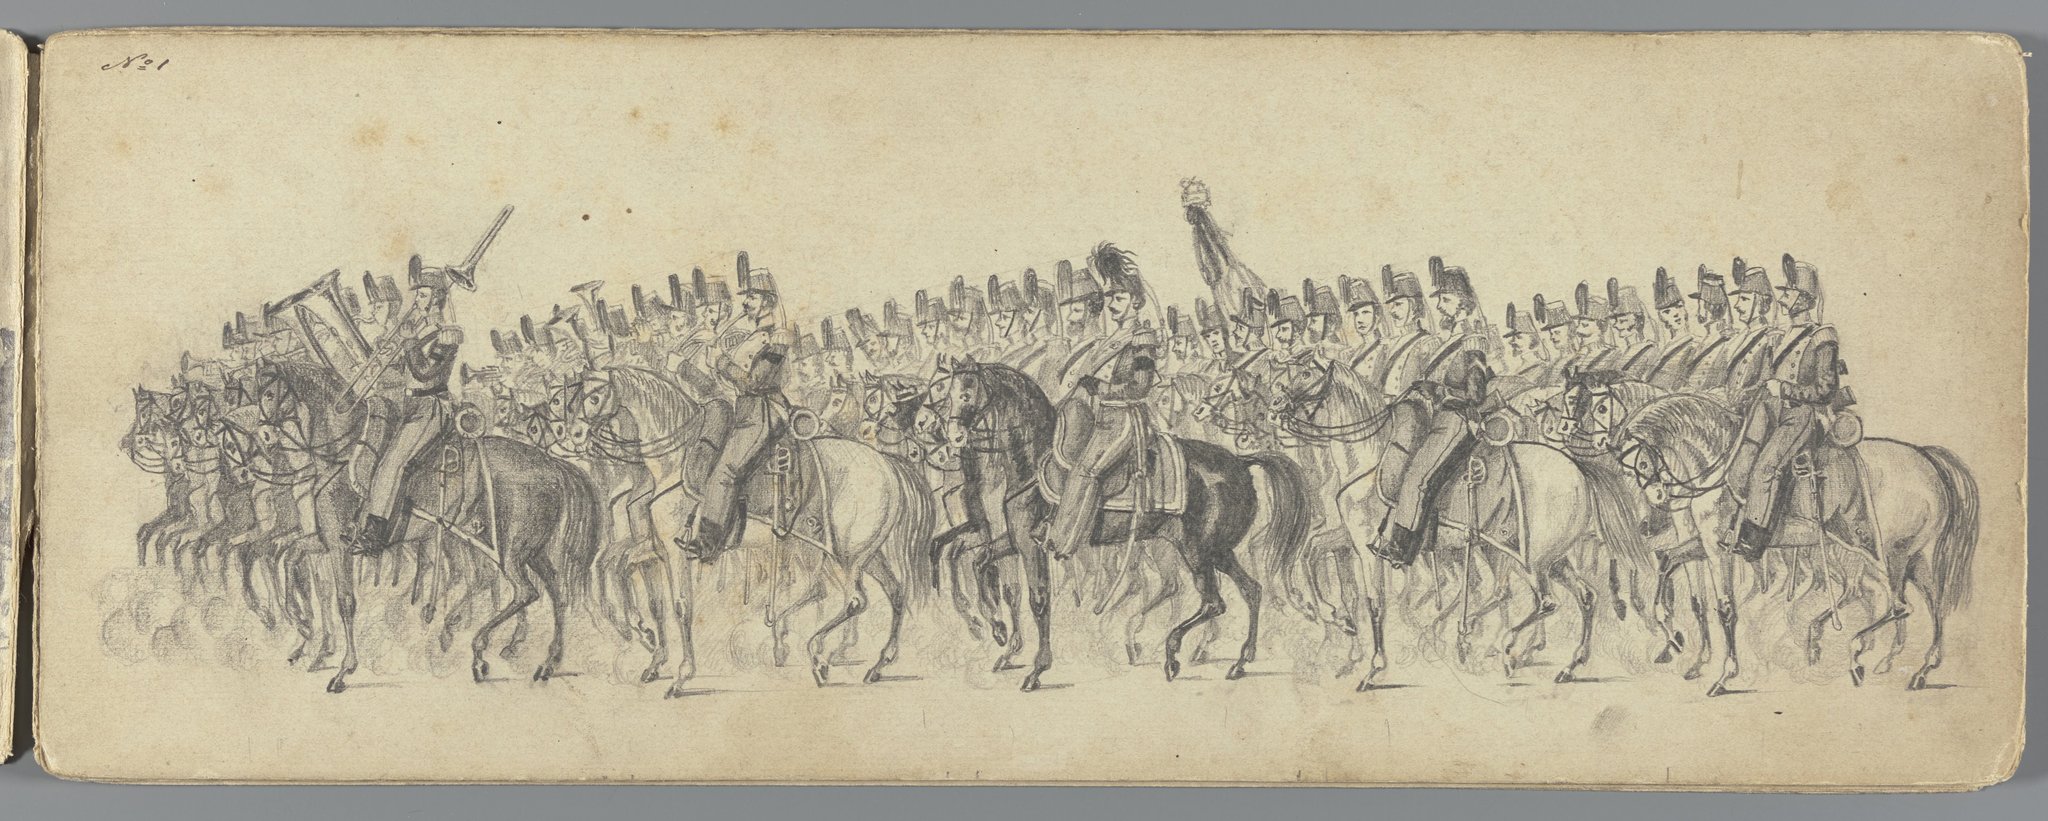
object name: drawing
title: Begrafenisstoet van Anna Paulowna (blad 1), 1865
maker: Anonymous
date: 1865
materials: paper, pencil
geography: netherlands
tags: anna paulowna romanowa, military music, cortege, funeral procession, delft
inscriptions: inscription: ‘No. 1’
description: Muziekkorps en militairen te paard. Eerste tafereel in een schetsboek met een weergave van de begrafenisstoet van wijlen koningin Anna Paulowna te Delft op 17 maart 1865, omslag met tien losse bladen.